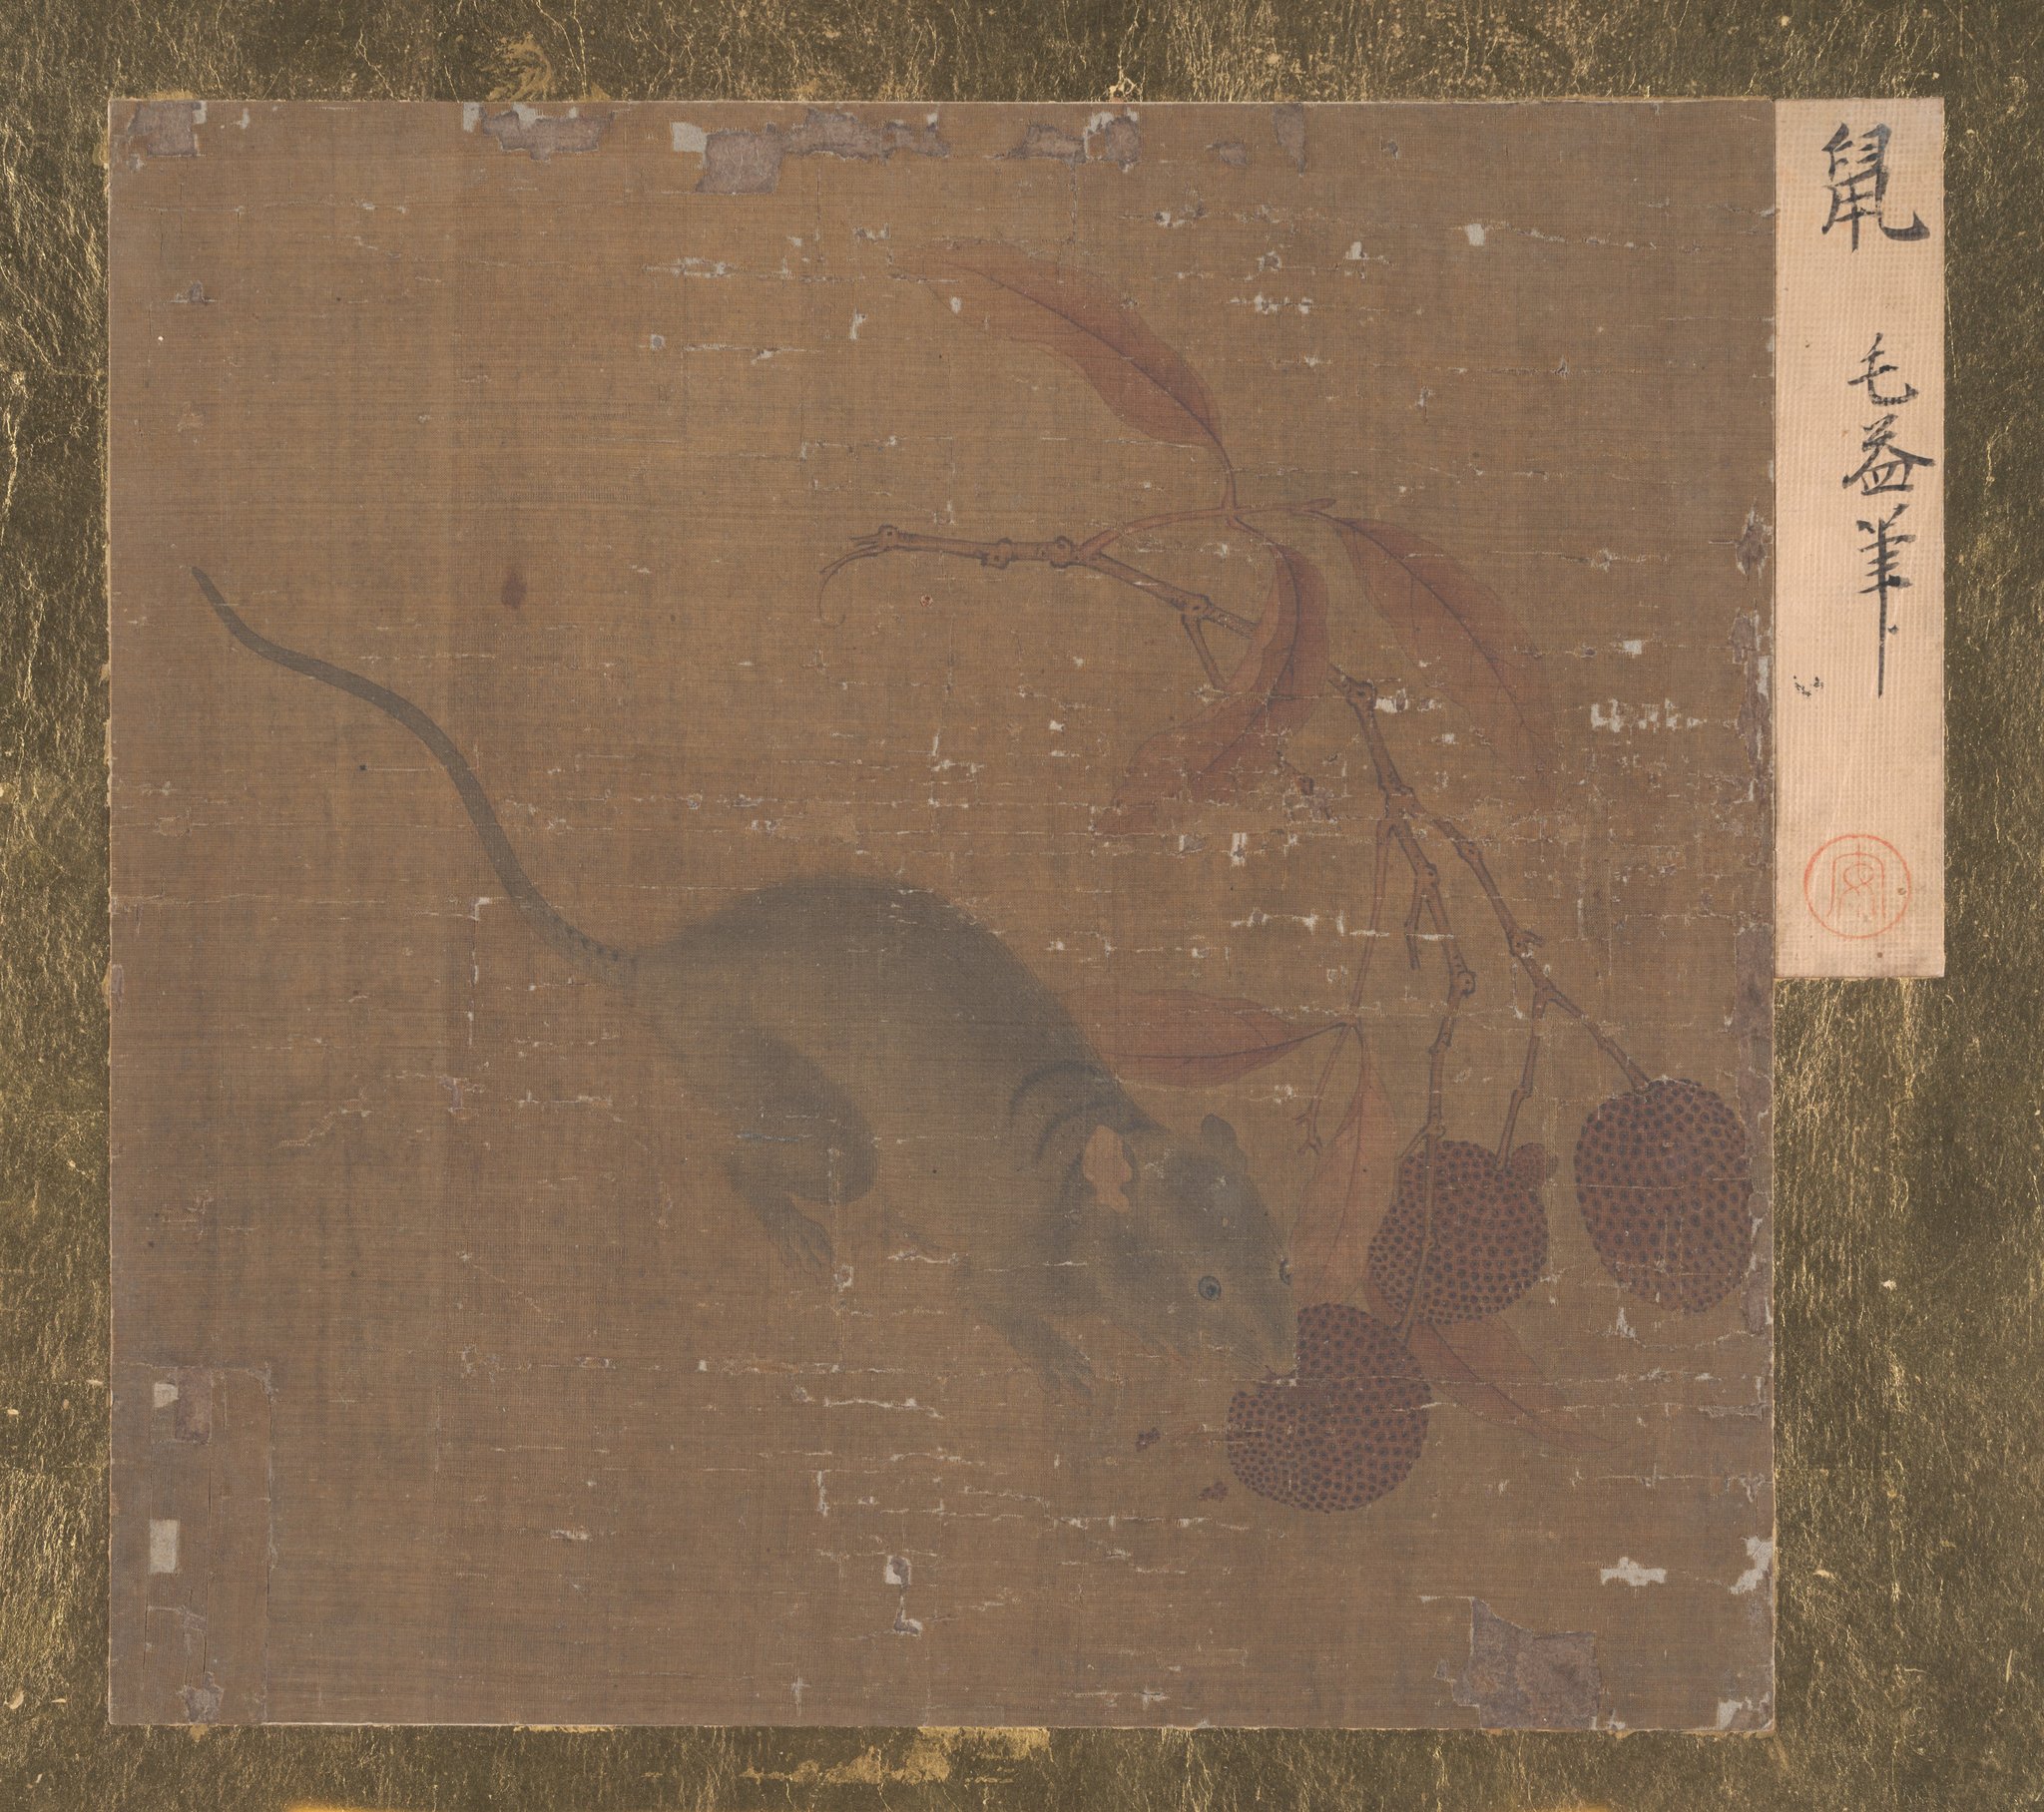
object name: album leaf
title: Mouse Eating Lichee Fruit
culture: chinese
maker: unidentified artist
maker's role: artist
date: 960-1279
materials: ink, silk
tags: fruit,mice